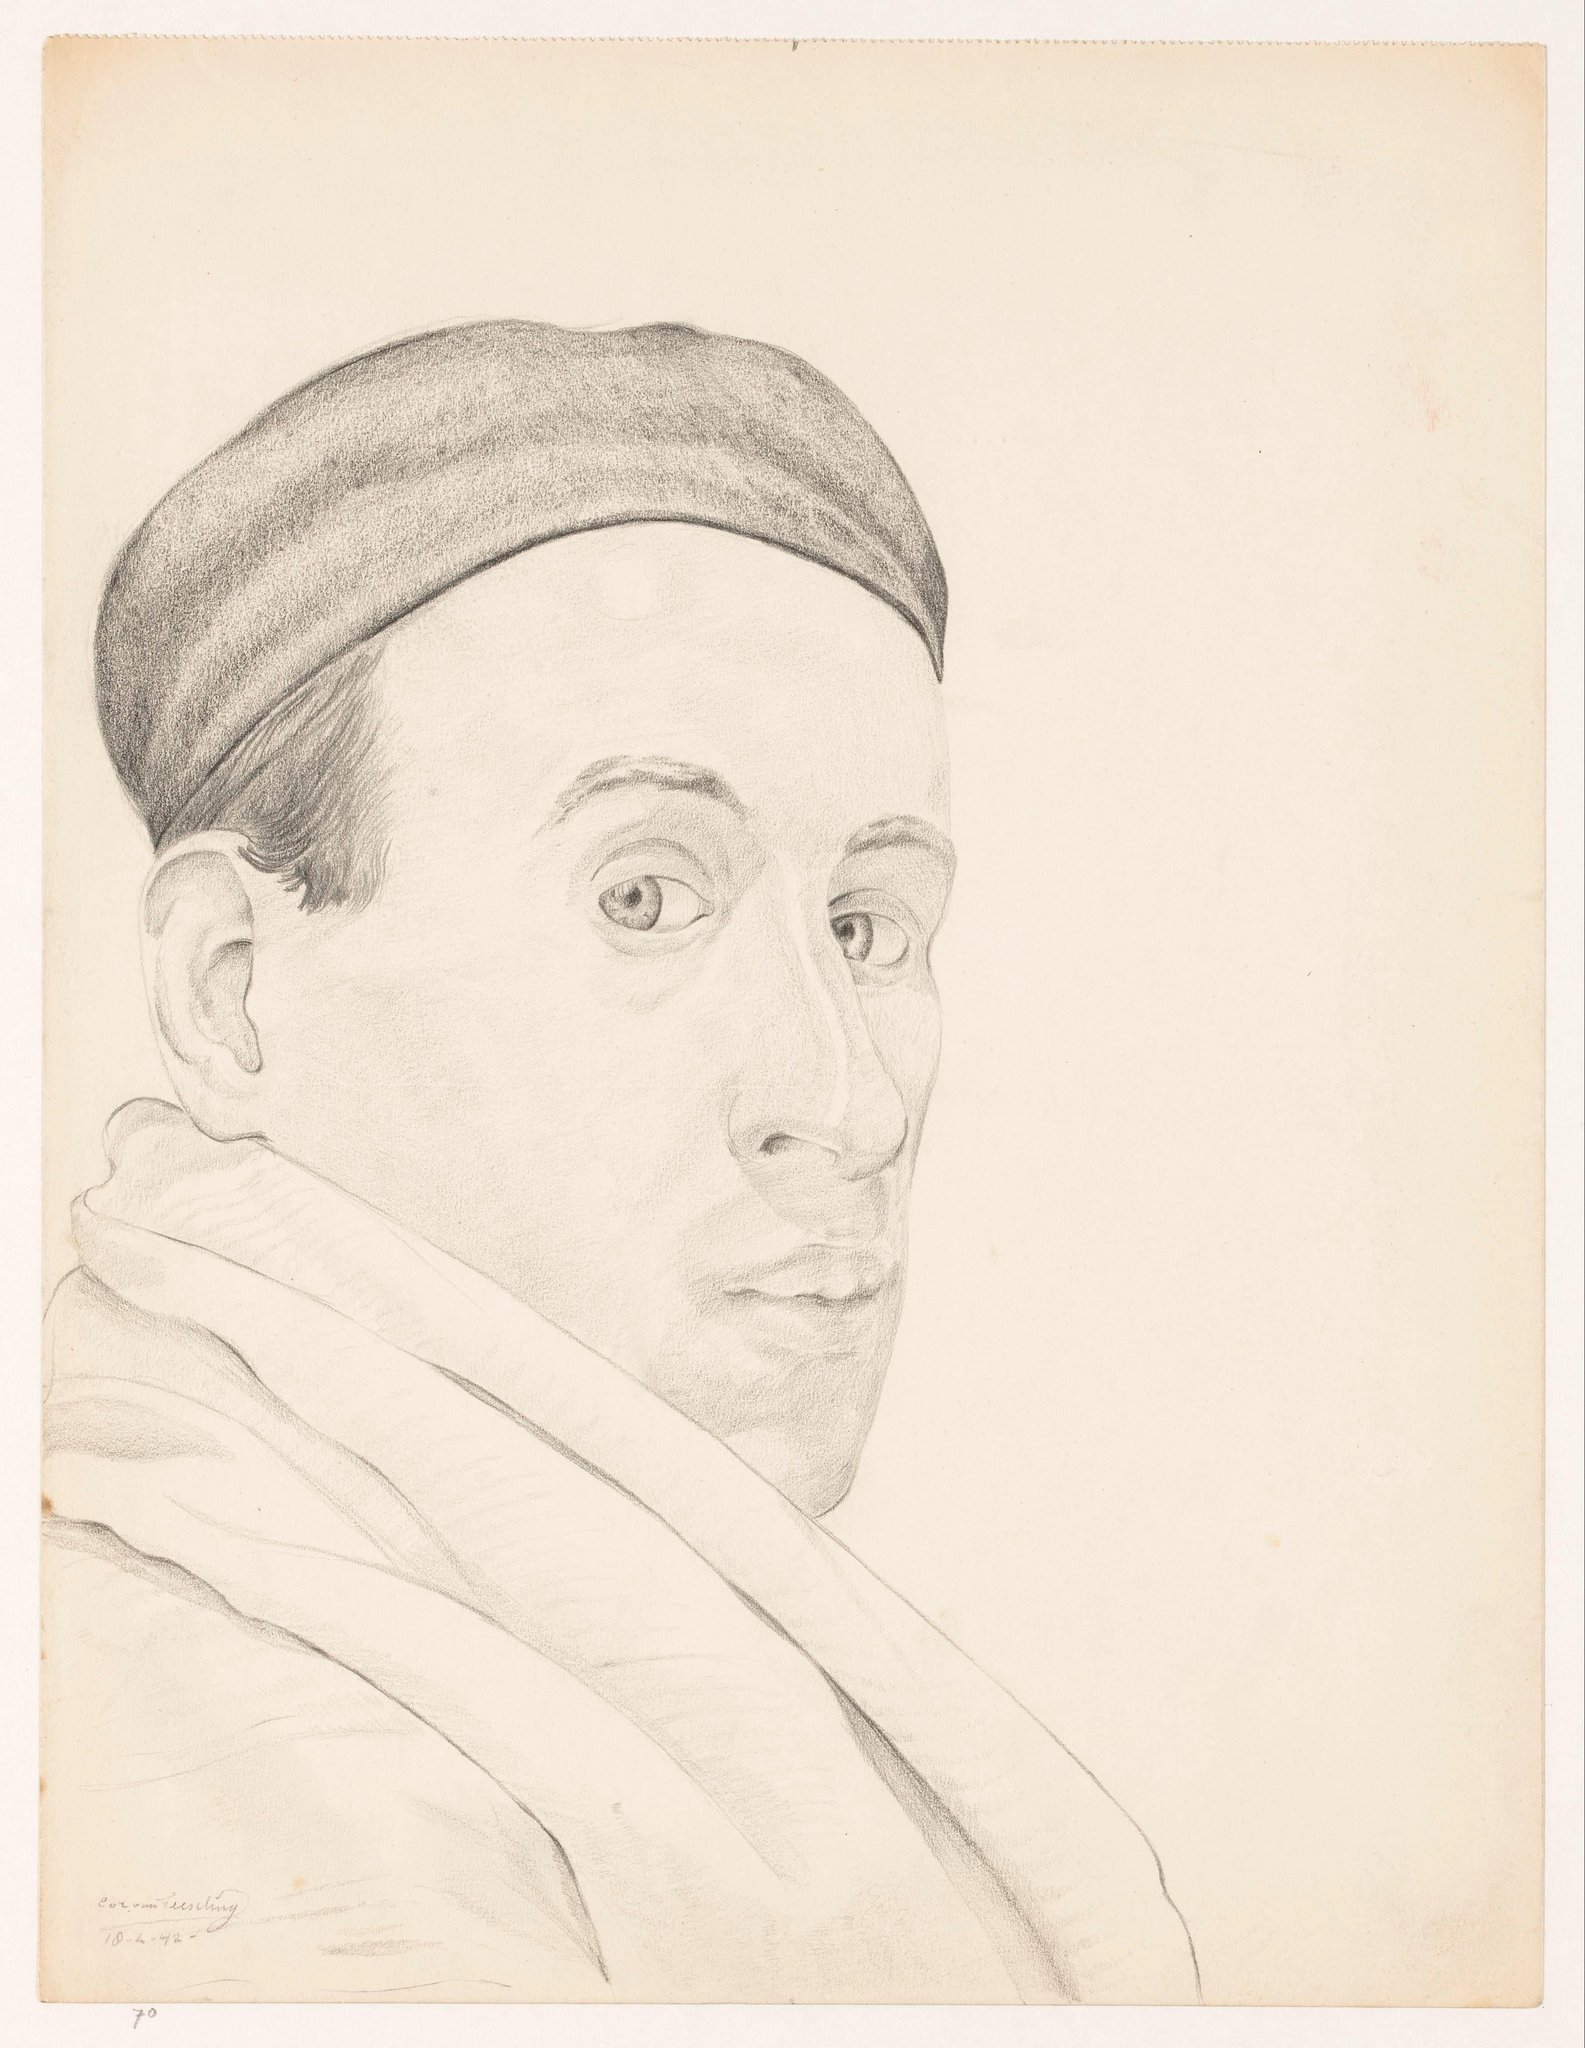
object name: drawing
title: Zelfportretten van Cor van Teeseling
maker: cor van teeseling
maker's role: draughtsman, sculptor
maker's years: 1915-1942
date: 1942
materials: paper, pencil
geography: weteringschans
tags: amsterdam, draughtsman, sculptor, cor van teeseling, historical persons, prisoner in cell or locked place, portrait, self-portrait of draughtsman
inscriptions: signature and date: ‘Cor van Teeseling / 18-2-42’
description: Zelfportret van Cor van Teeseling met pet: B-1-1, 18 februari. Getekend zelfportret van Cor van Teeseling driekwart, zijn gezicht naar rechts gewend.